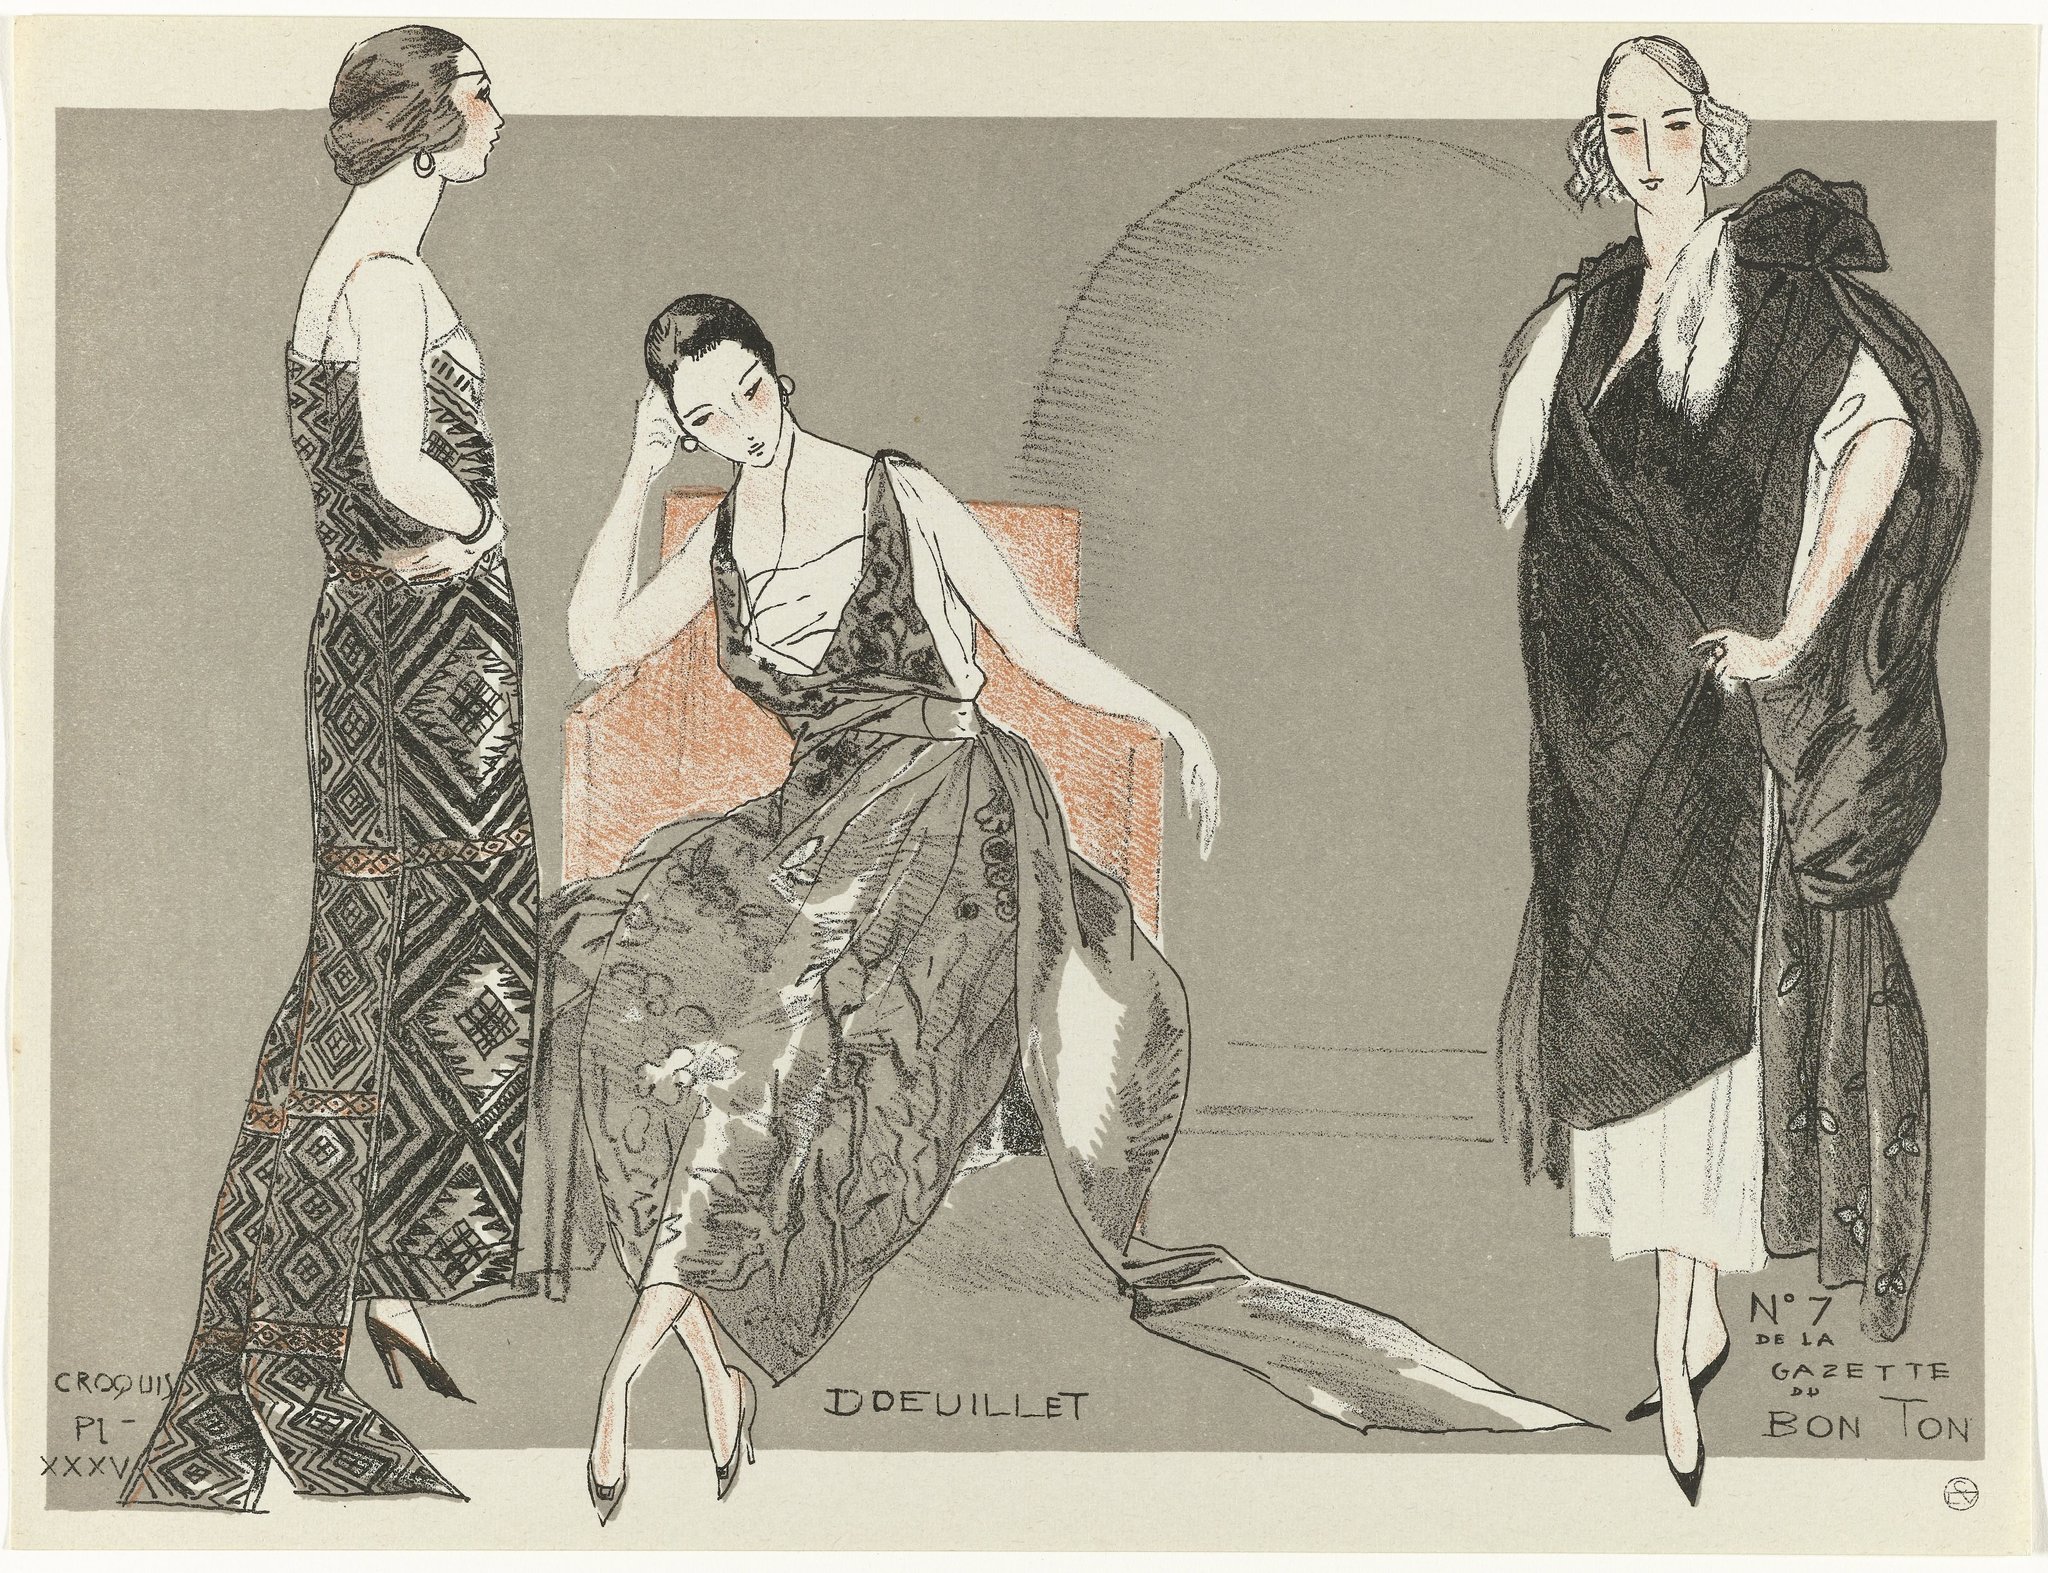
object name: fashion print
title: Gazette du Bon Ton, 1920 - No. 7, Croquis Pl. XXXV: Doeuillet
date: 1920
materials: paper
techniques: lithograph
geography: geneva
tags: ear-rings (+ women's clothes), armchair, seat, dress, gown: evening dress (+ women's clothes), coat (evening coat) (+ women's clothes), fashion plates, bracelet, wristlet (+ women's clothes), necklace (+ women's clothes)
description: Twee staande en één zittende vrouw gekleed in avondjaponnen en een avondmantel van Doeuillet. Croquis Pl XXXV uit Gazette du Bon Ton 1920, No. 7. Uitleg over de kleding op pagina "Explication des Planches".